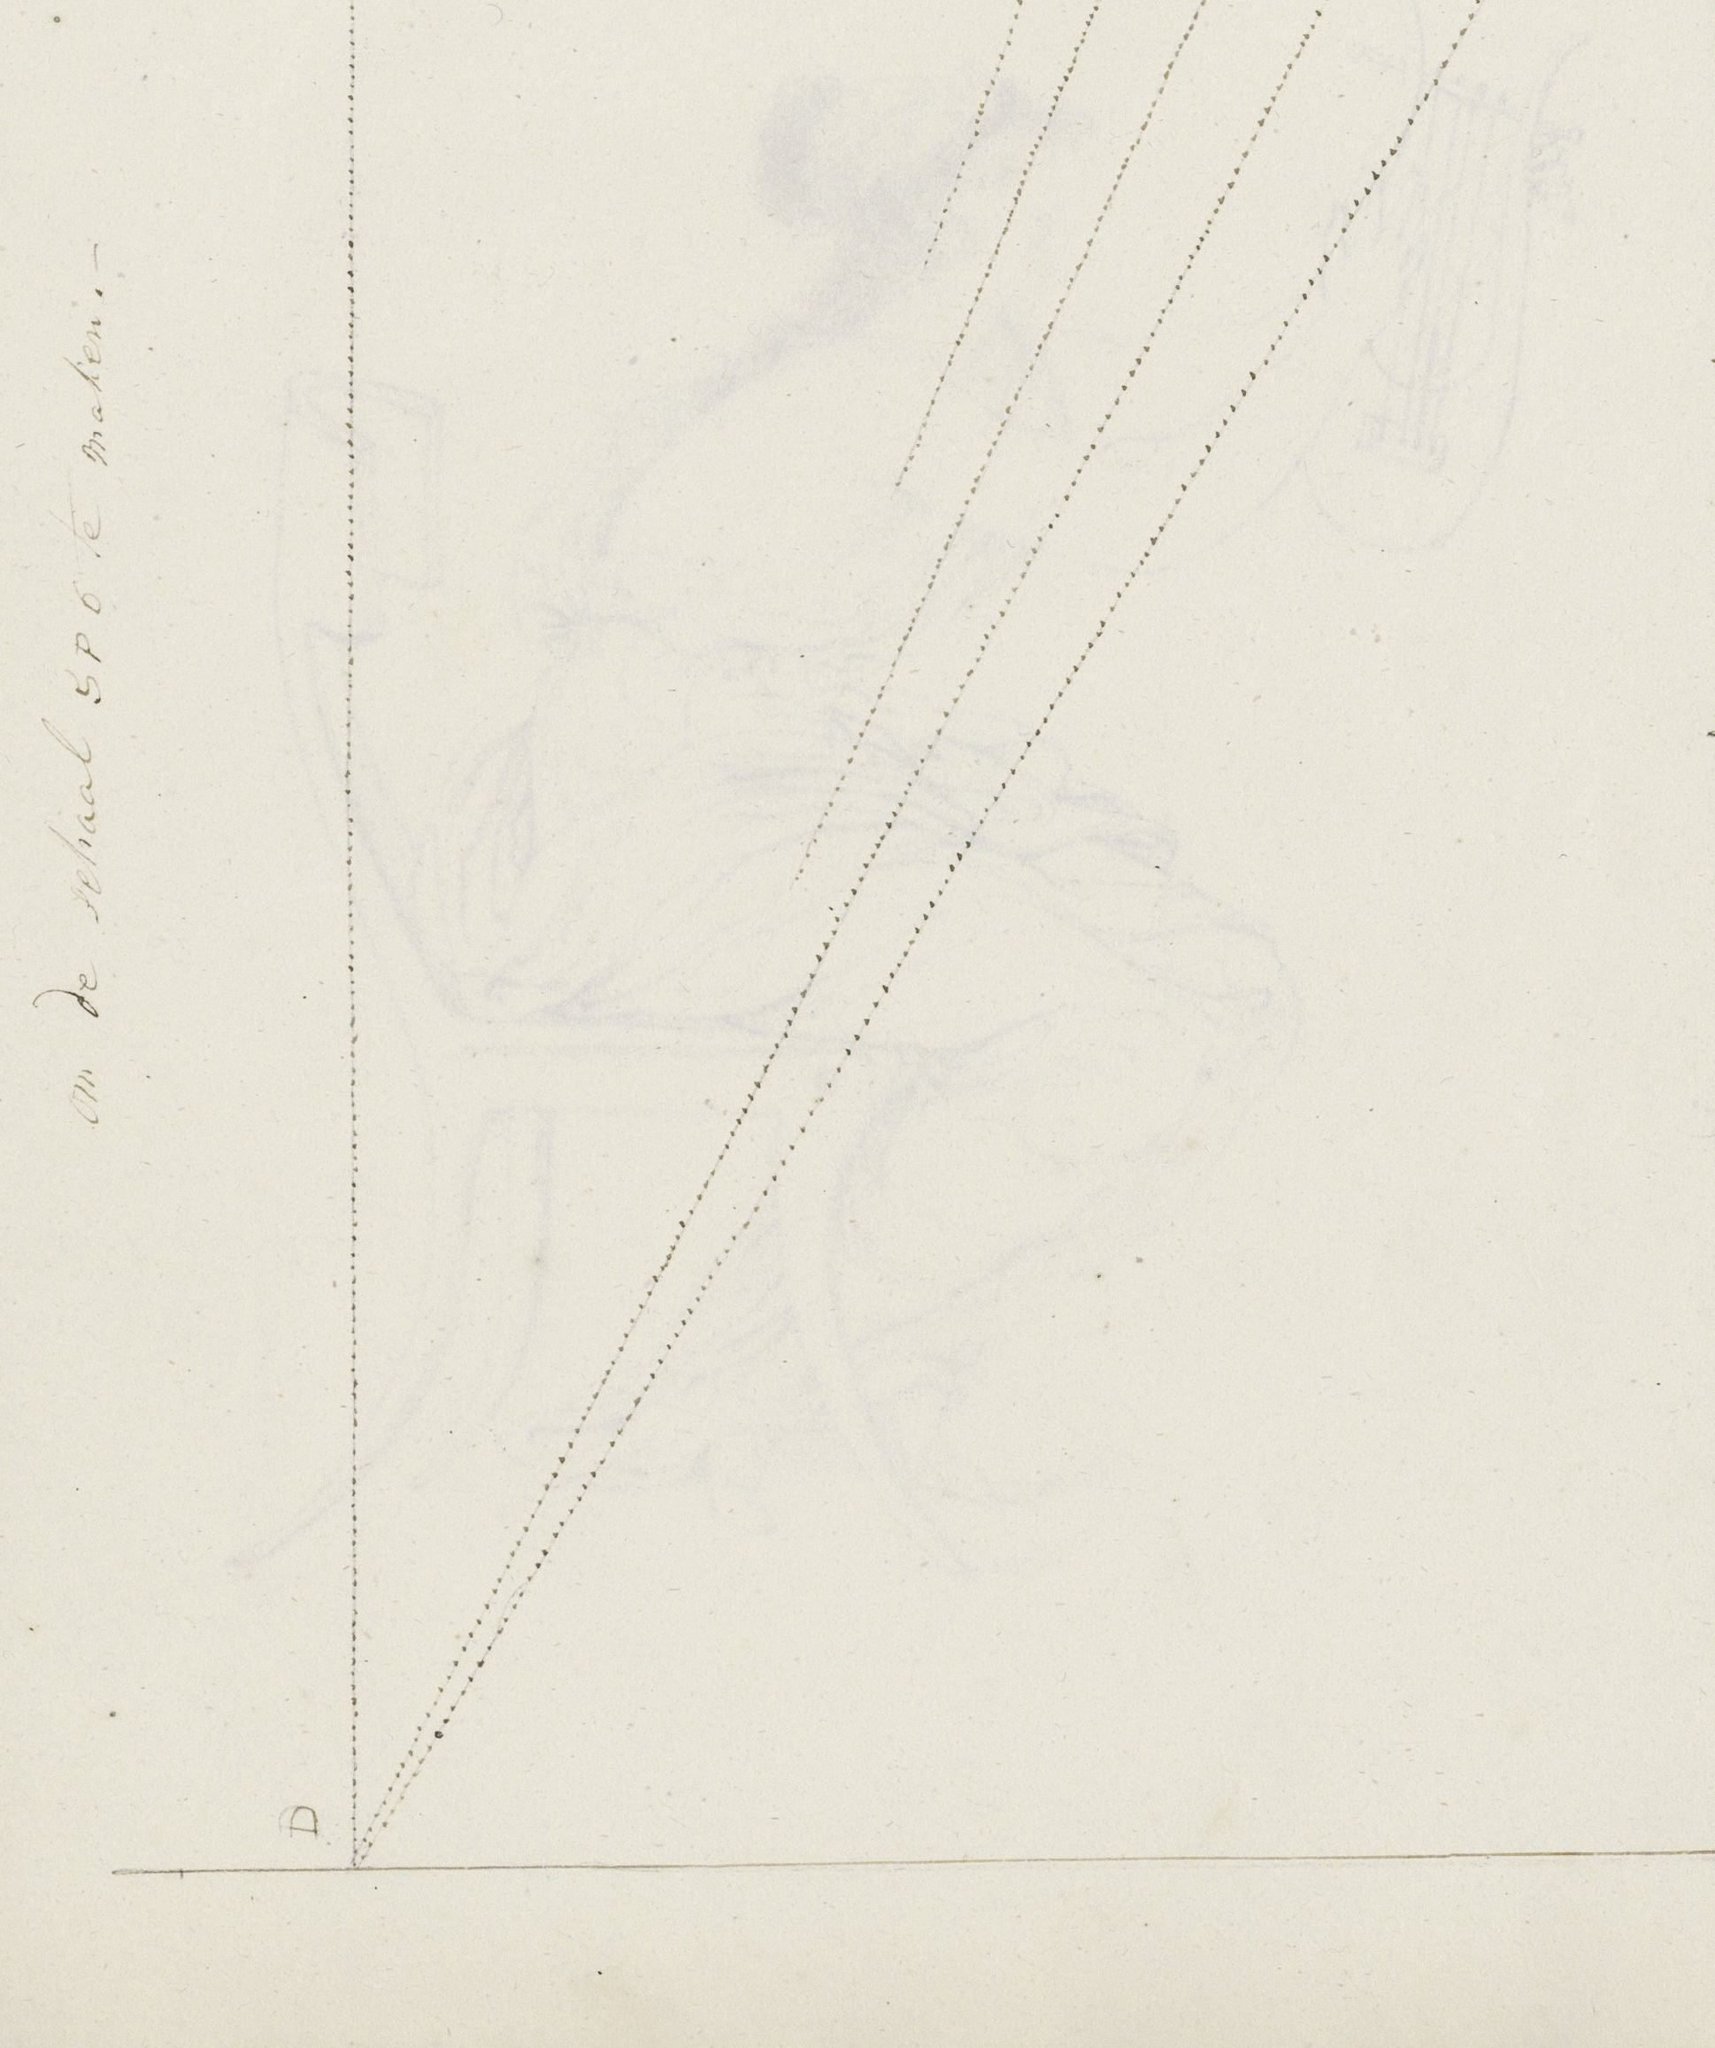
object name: sketchbook leaf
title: Perspectiefoefening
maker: jonkvrouw elisabeth kemper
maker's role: draughtsman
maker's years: 1799-1871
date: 1815-1852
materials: ink, paper, pencil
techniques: pen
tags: mathematical perspective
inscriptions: annotation: ‘om de schaal SP6 te maken./ 1 2 3 4 5/ 5/ 4/ 3/ 2/ 1’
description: Blad 8 recto uit een schetsboek met 94 bladen.